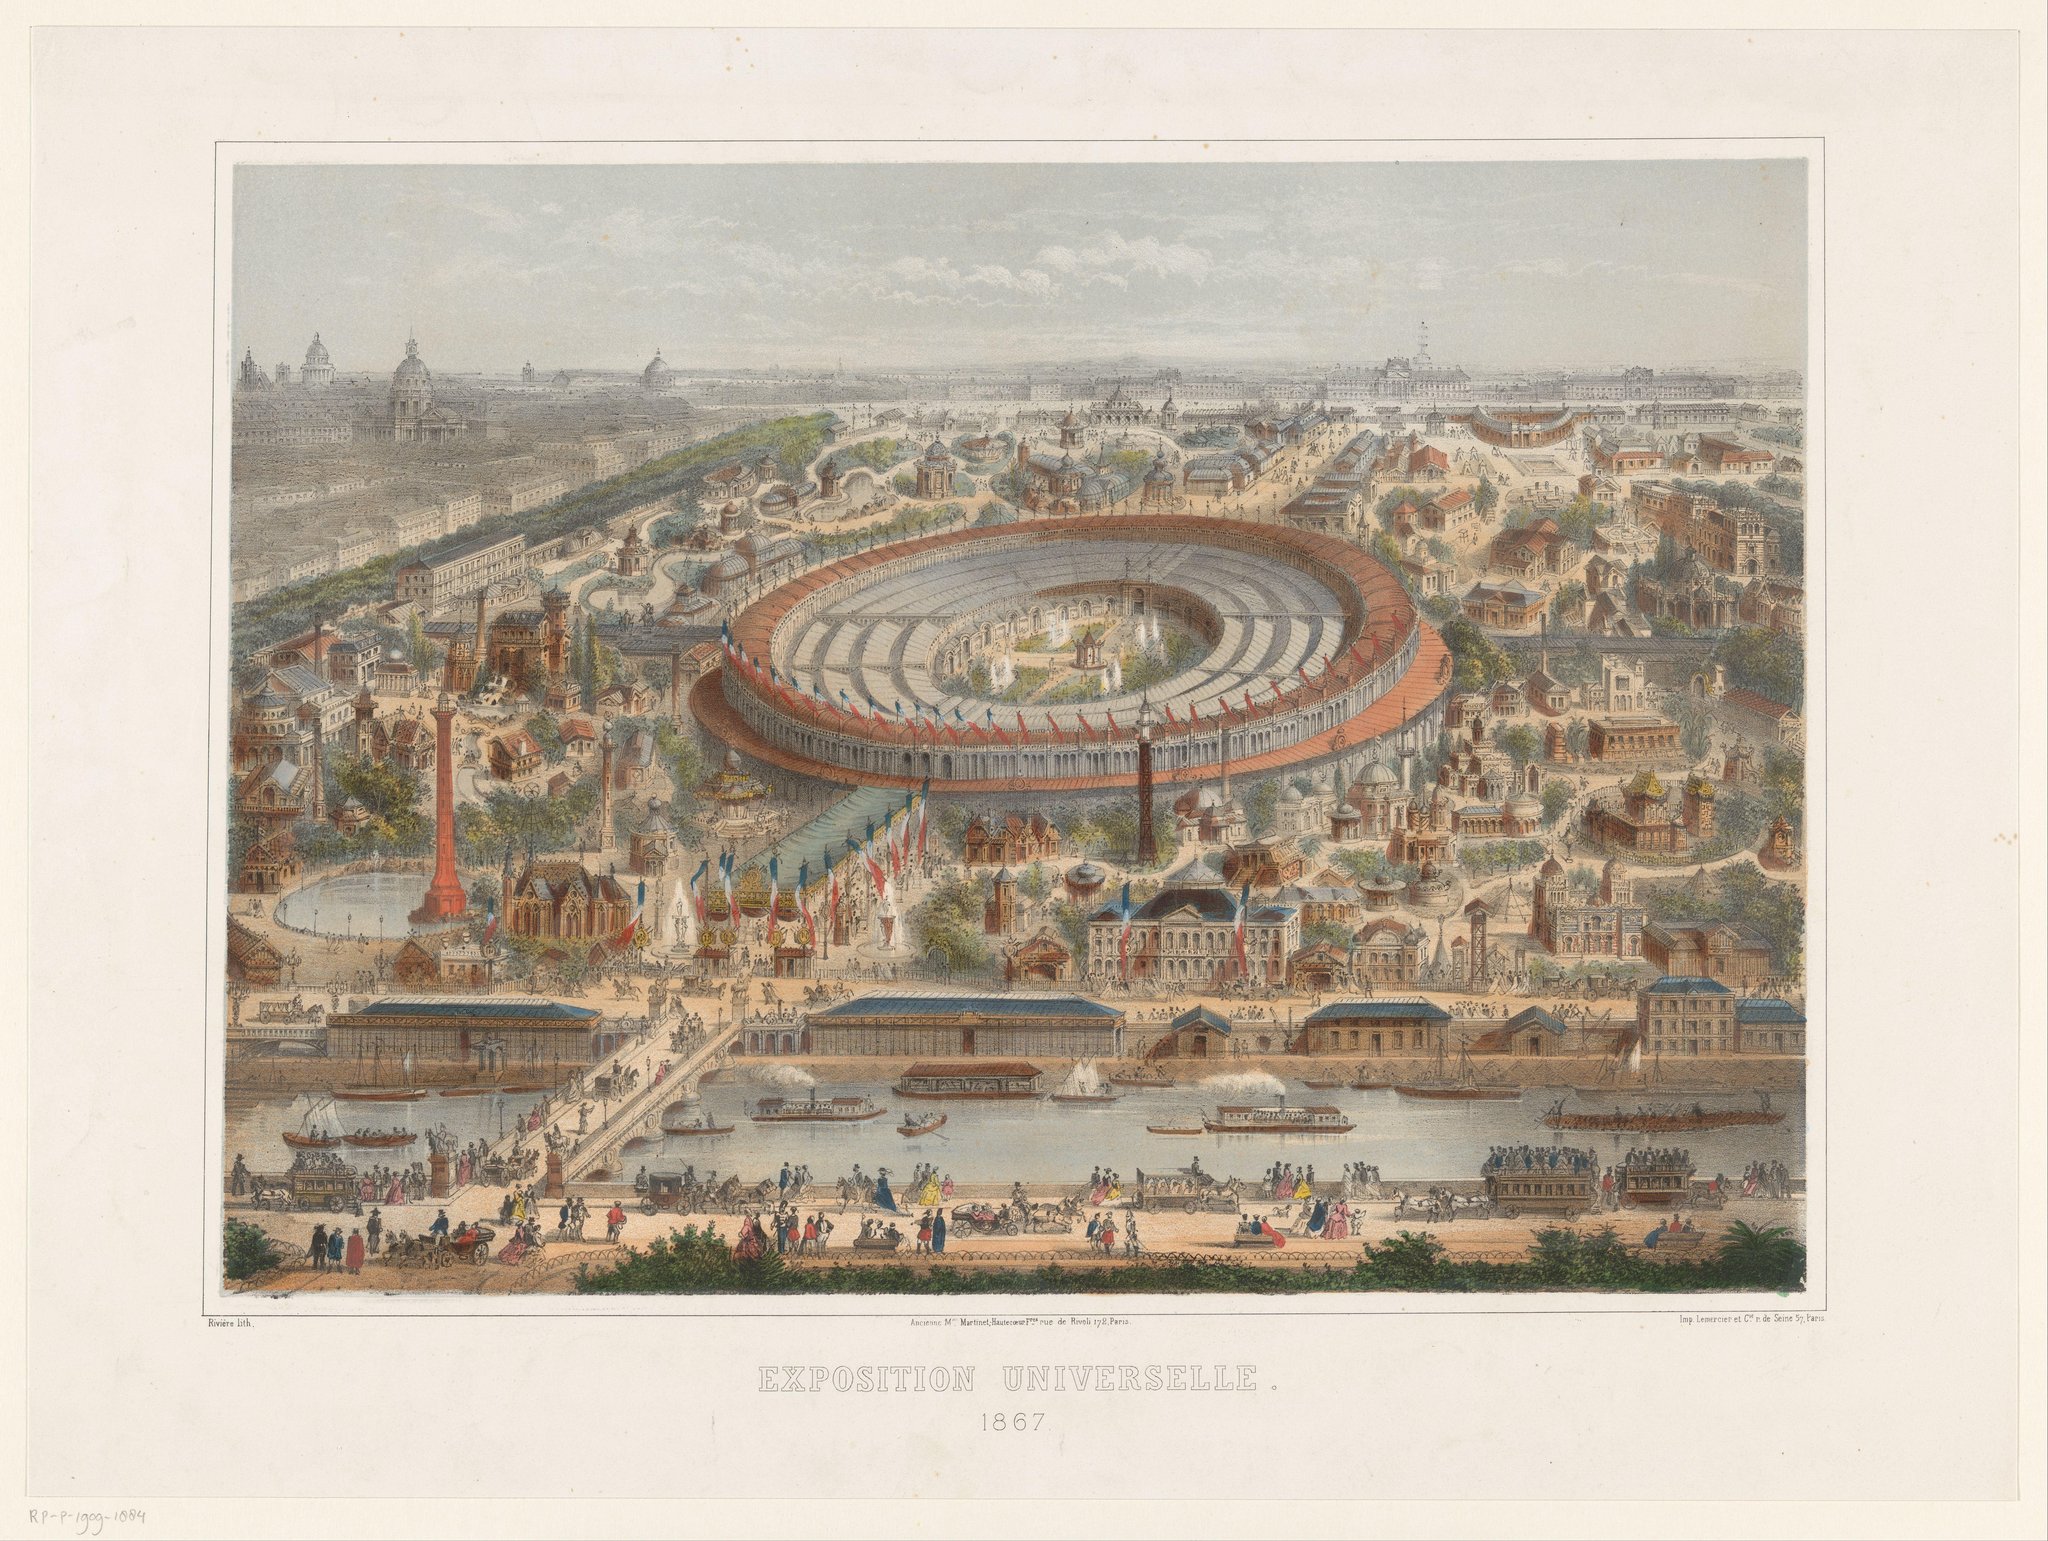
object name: print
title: Vogelvlucht van de wereldtentoonstelling van 1867 in Parijs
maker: rivière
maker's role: print maker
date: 1867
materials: lacquer, paper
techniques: lithograph, lacquer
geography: paris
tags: world fair, world exhibition, paris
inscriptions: collector's mark: Lugt 2228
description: Gezicht het terrein van de wereldtentoonstelling van 1867 gehouden in Parijs.